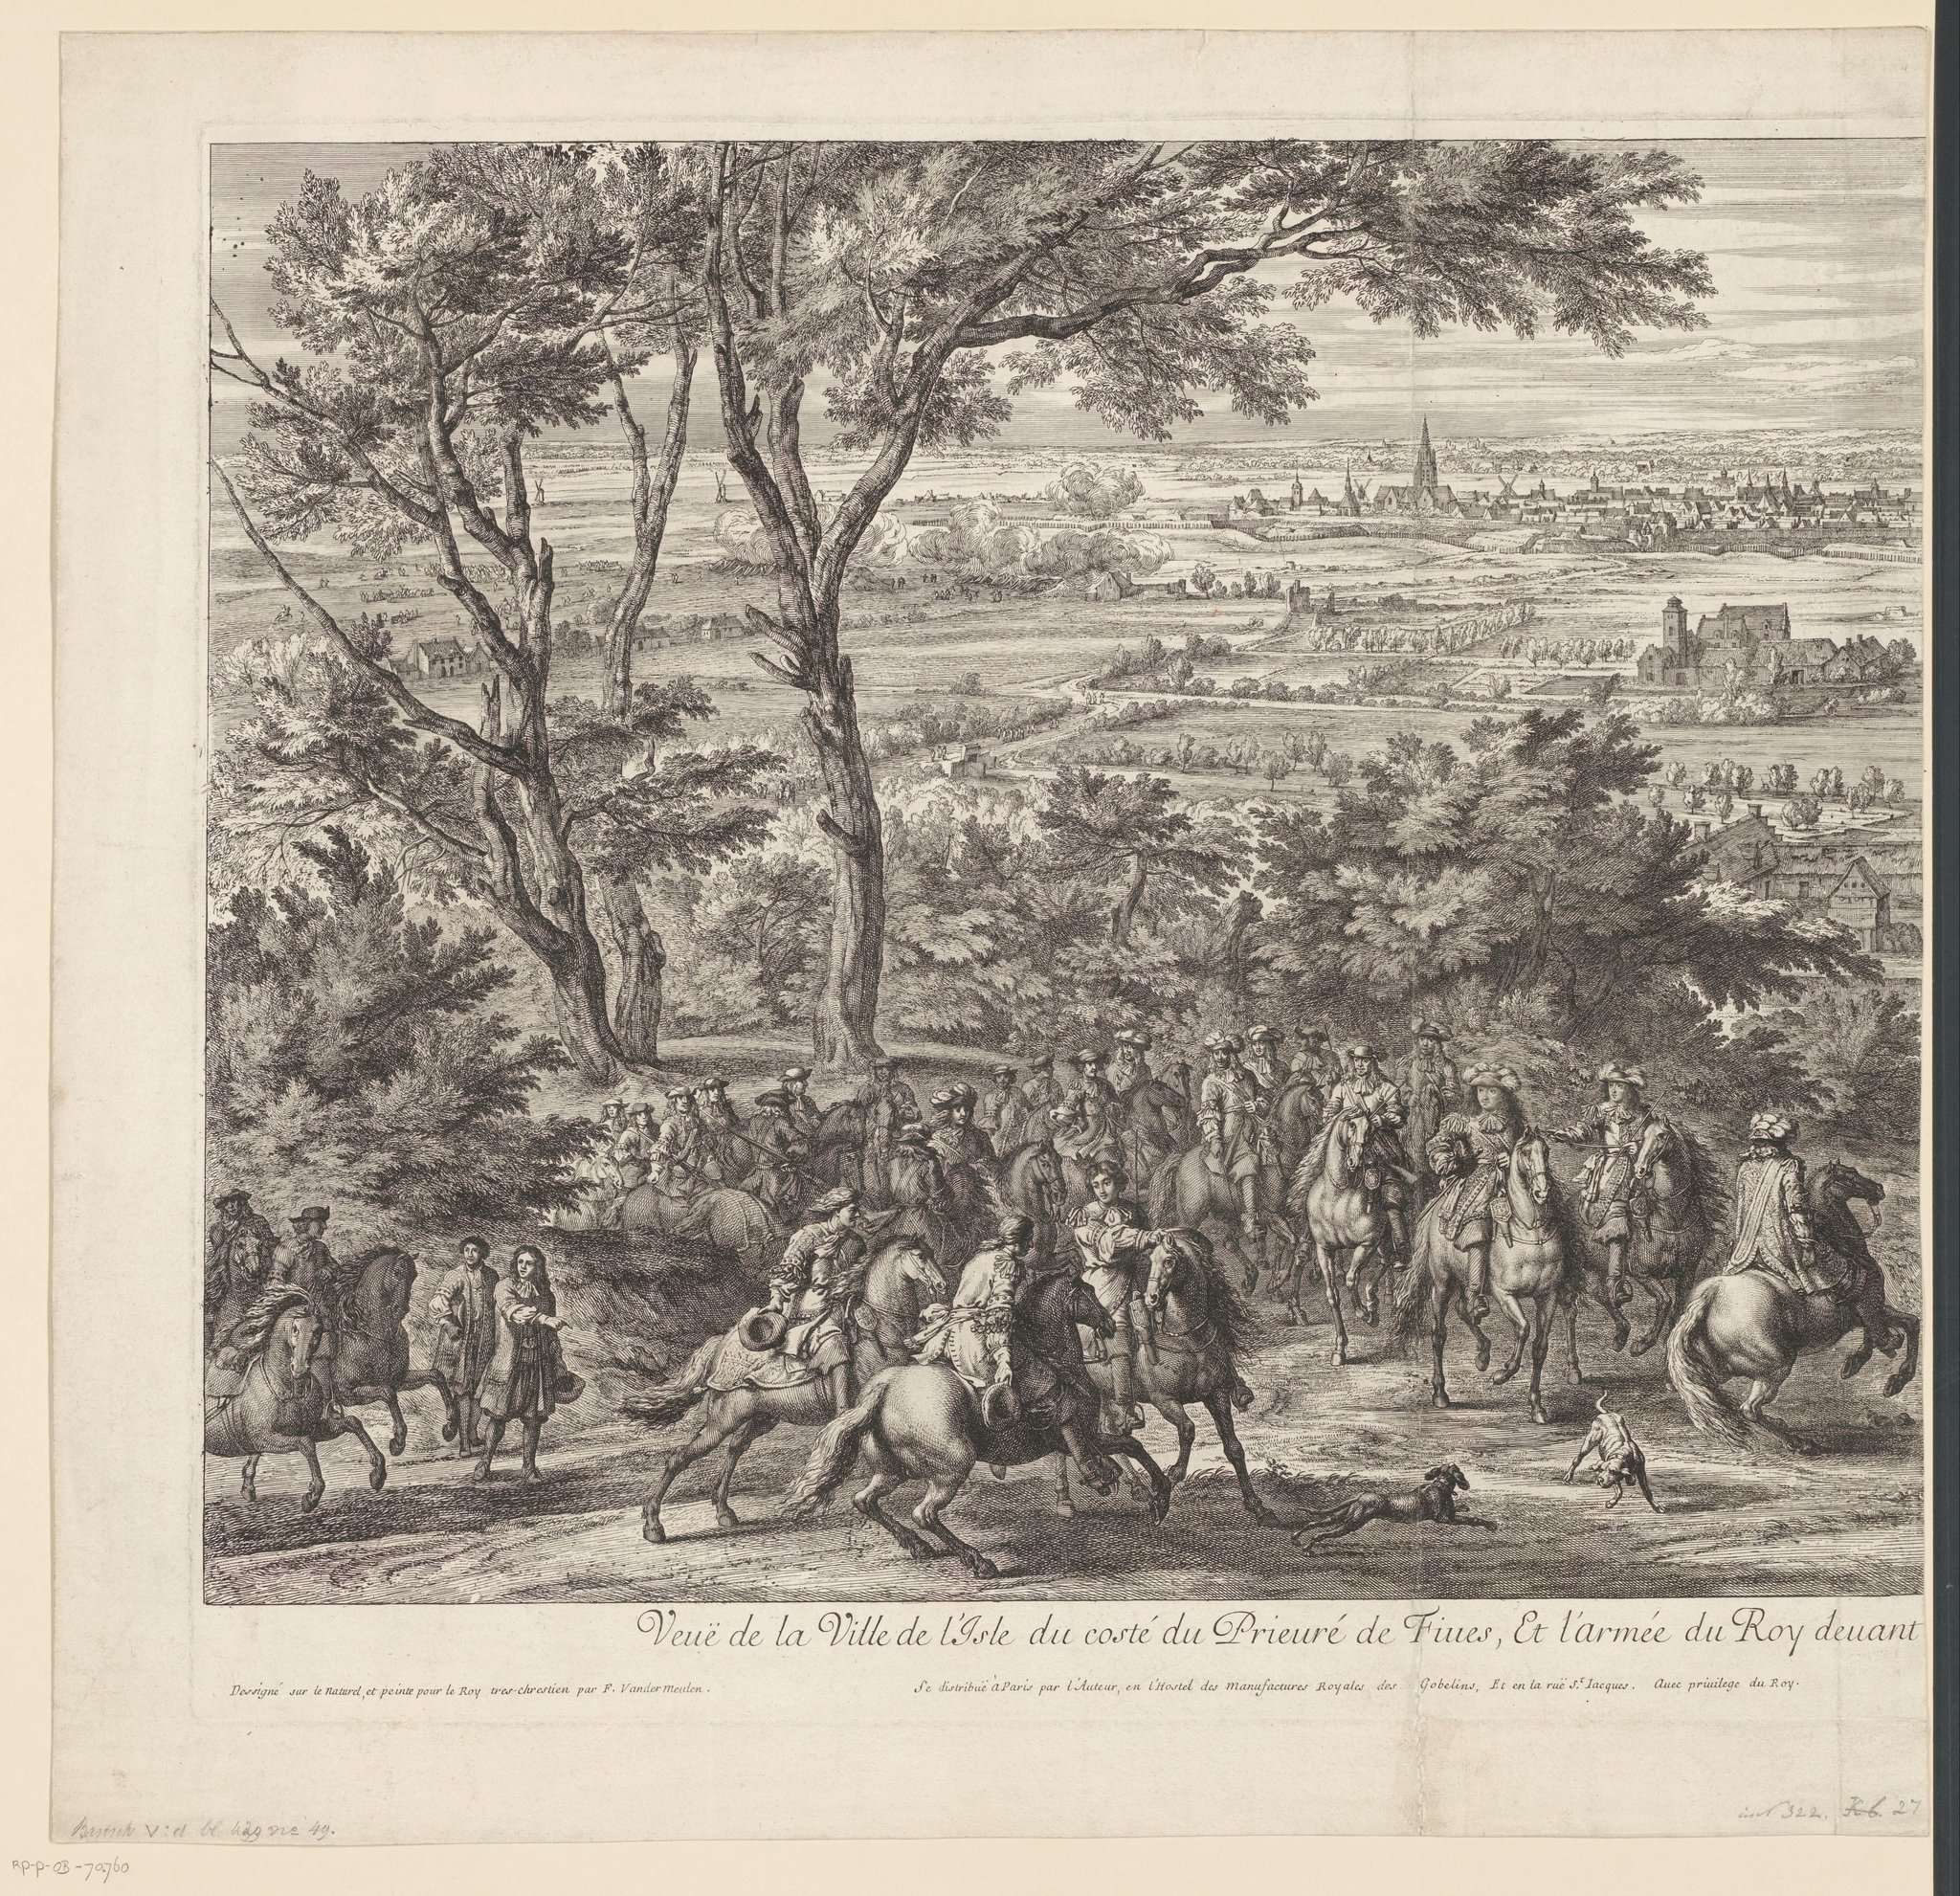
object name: print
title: Veuë de la Ville de l'Isle du costé du Prieuré de Fiues, Et l'armée du Roy deuant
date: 1685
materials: paper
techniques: engraving, etching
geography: amsterdam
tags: trees, city-view in general; 'veduta', anonymous historical persons portrayed in a group, in a group-portrait, lille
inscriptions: collector's mark: Lugt 240